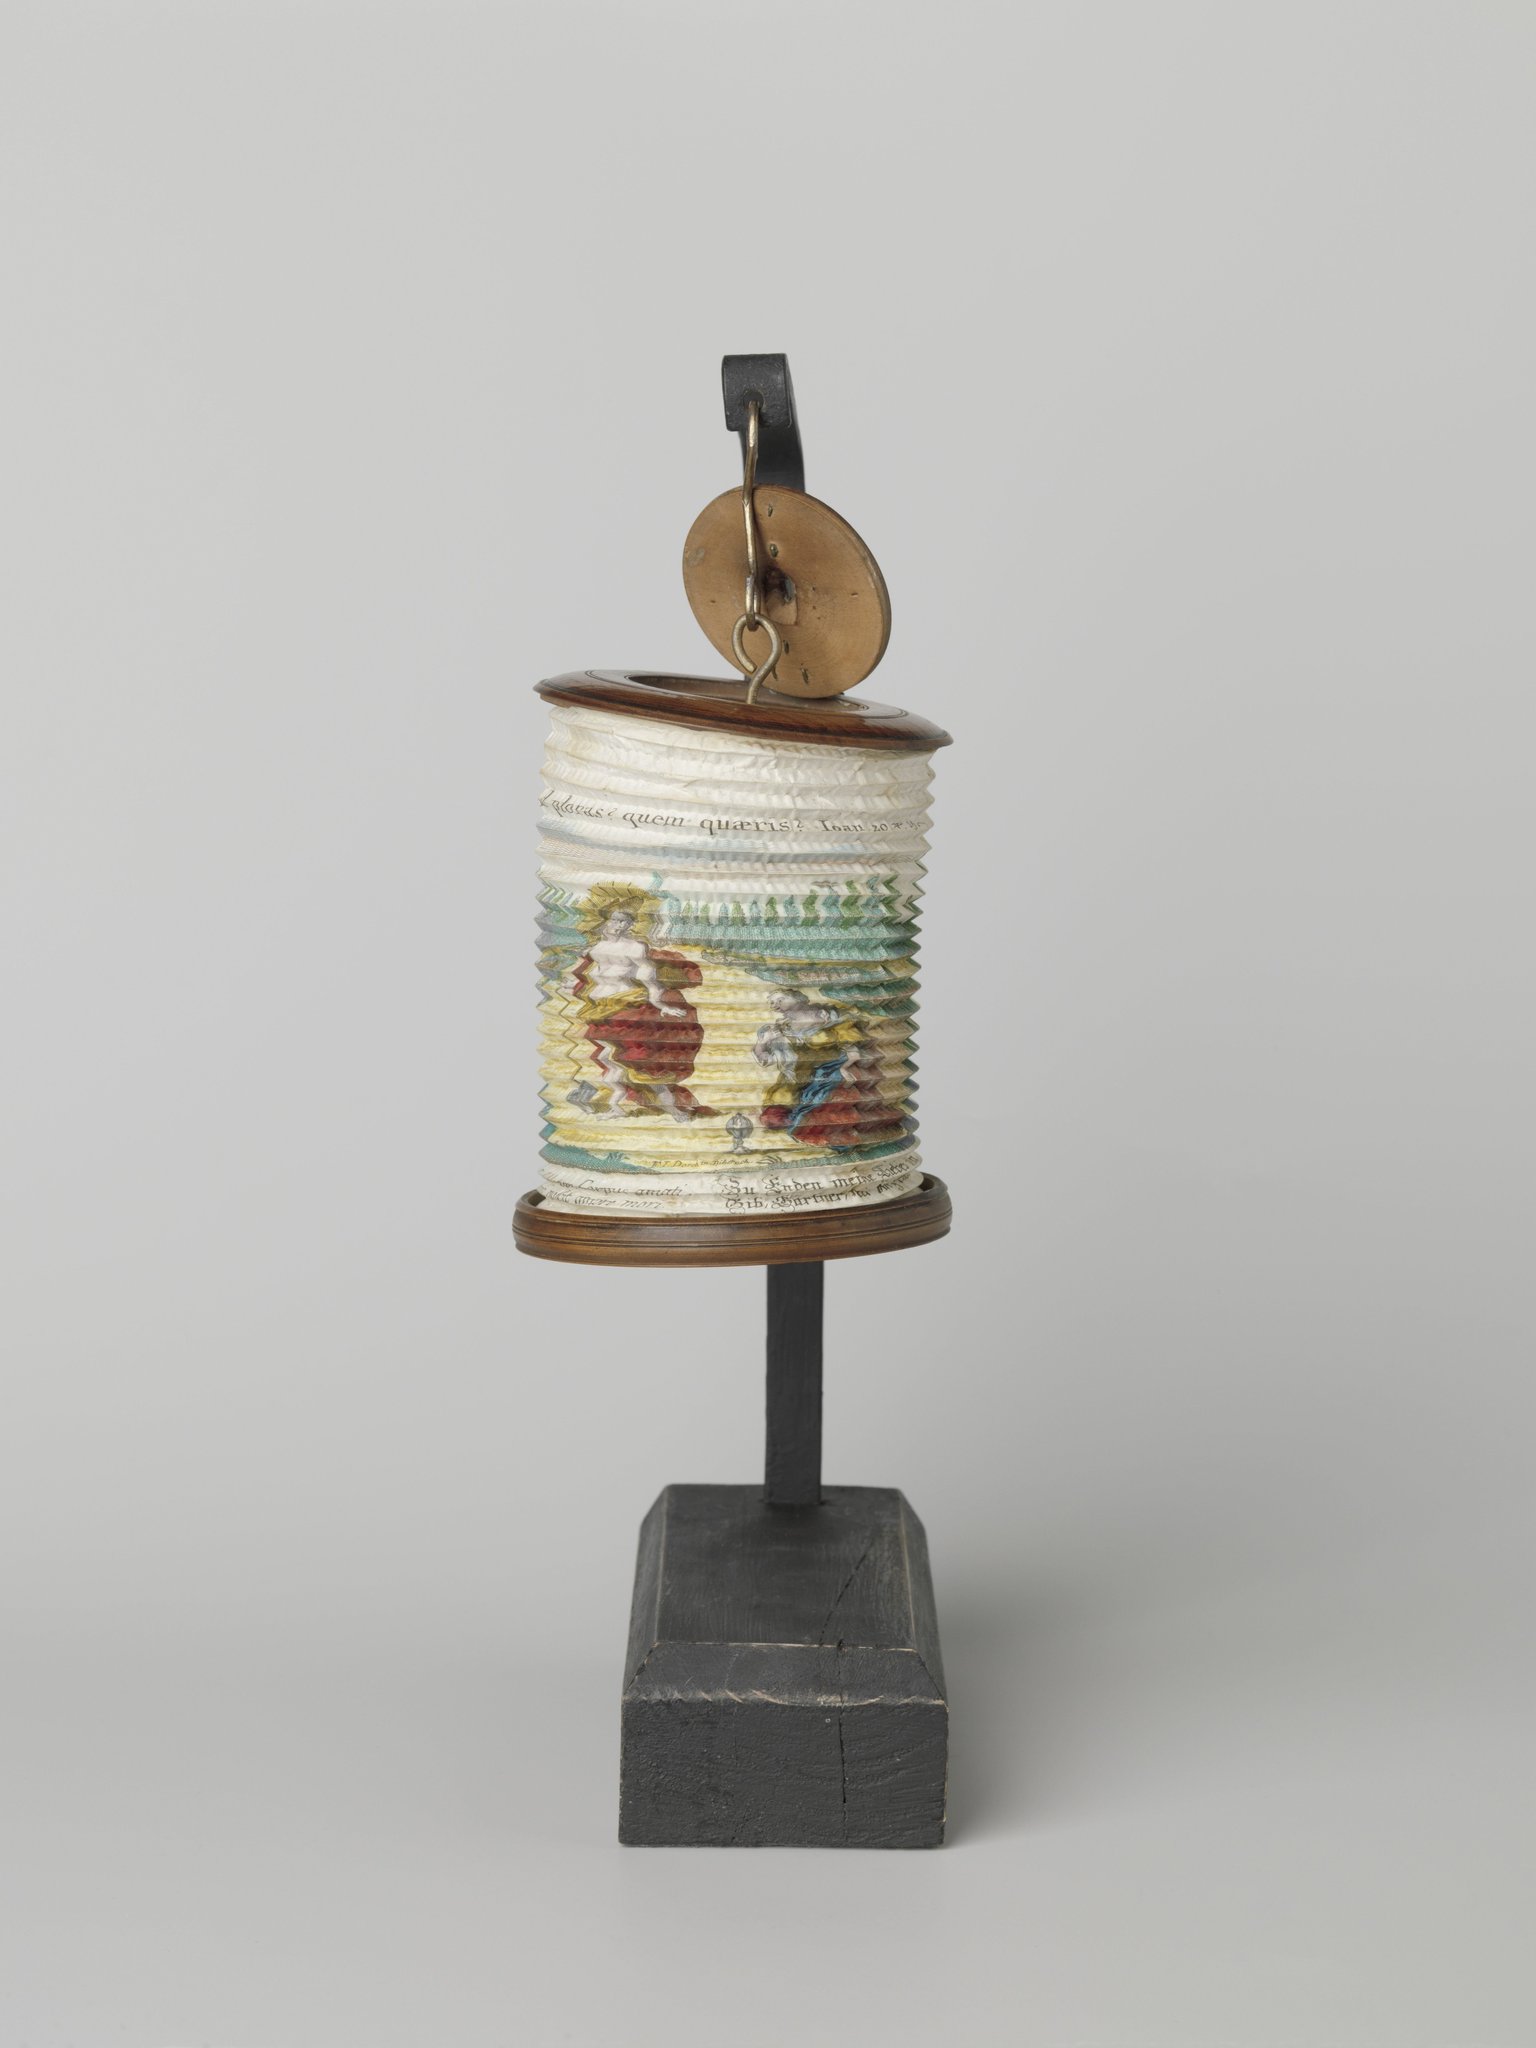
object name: lantern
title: Lantern with Christ in the Guise of a Gardener and Mary Magdalene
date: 1680-1720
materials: paper, wood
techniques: engraving, hand coloring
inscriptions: name: ‘I. Bosch in Biberach’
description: The maker of this lantern took a print depicting Christ as a gardener and Mary Magdalene and pleated it many times, shaped it into a circle, and sewed it together with needle and thread. The print can be folded into a small, round wooden box. This box is created when the wooden top and bottom of the lantern are fastened with a tiny metal pin.